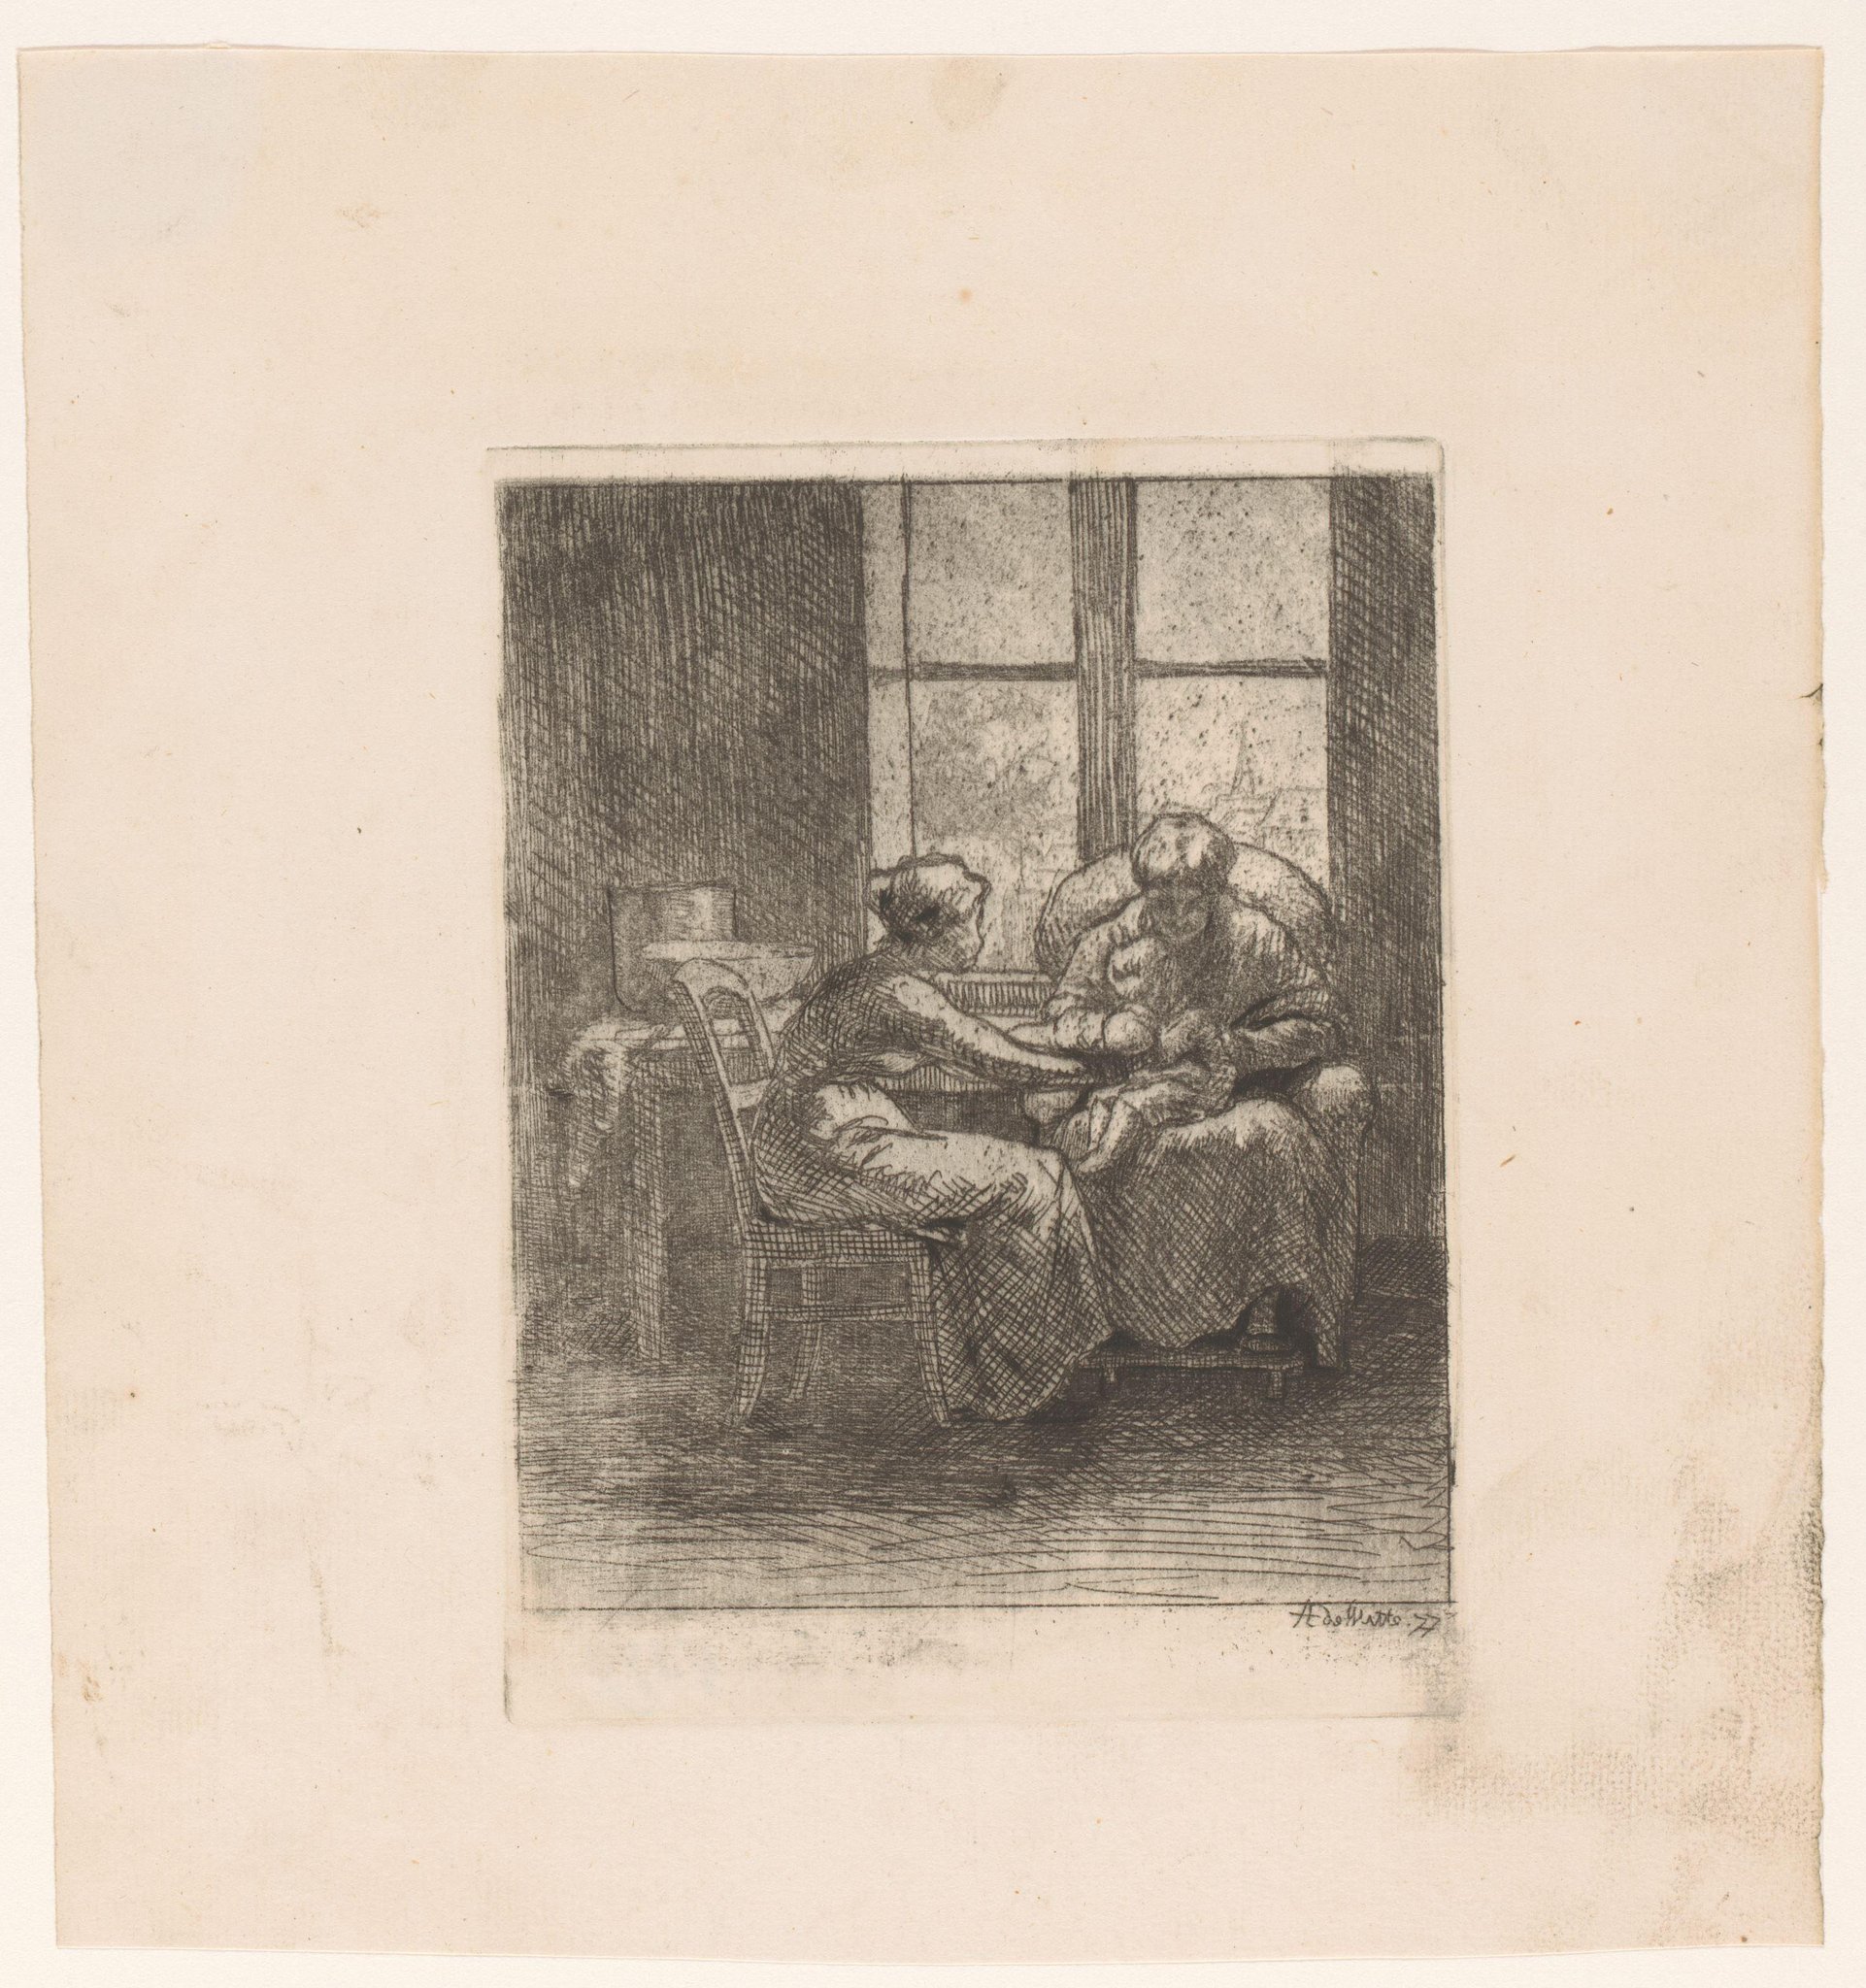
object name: print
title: Interieur met familietafereel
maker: adrien de witte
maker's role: print maker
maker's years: 1850-1935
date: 1877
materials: paper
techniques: etching, intaglio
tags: interior of the house, mother and baby or young child, three generations (family group)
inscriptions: collector's mark: Lugt 2228